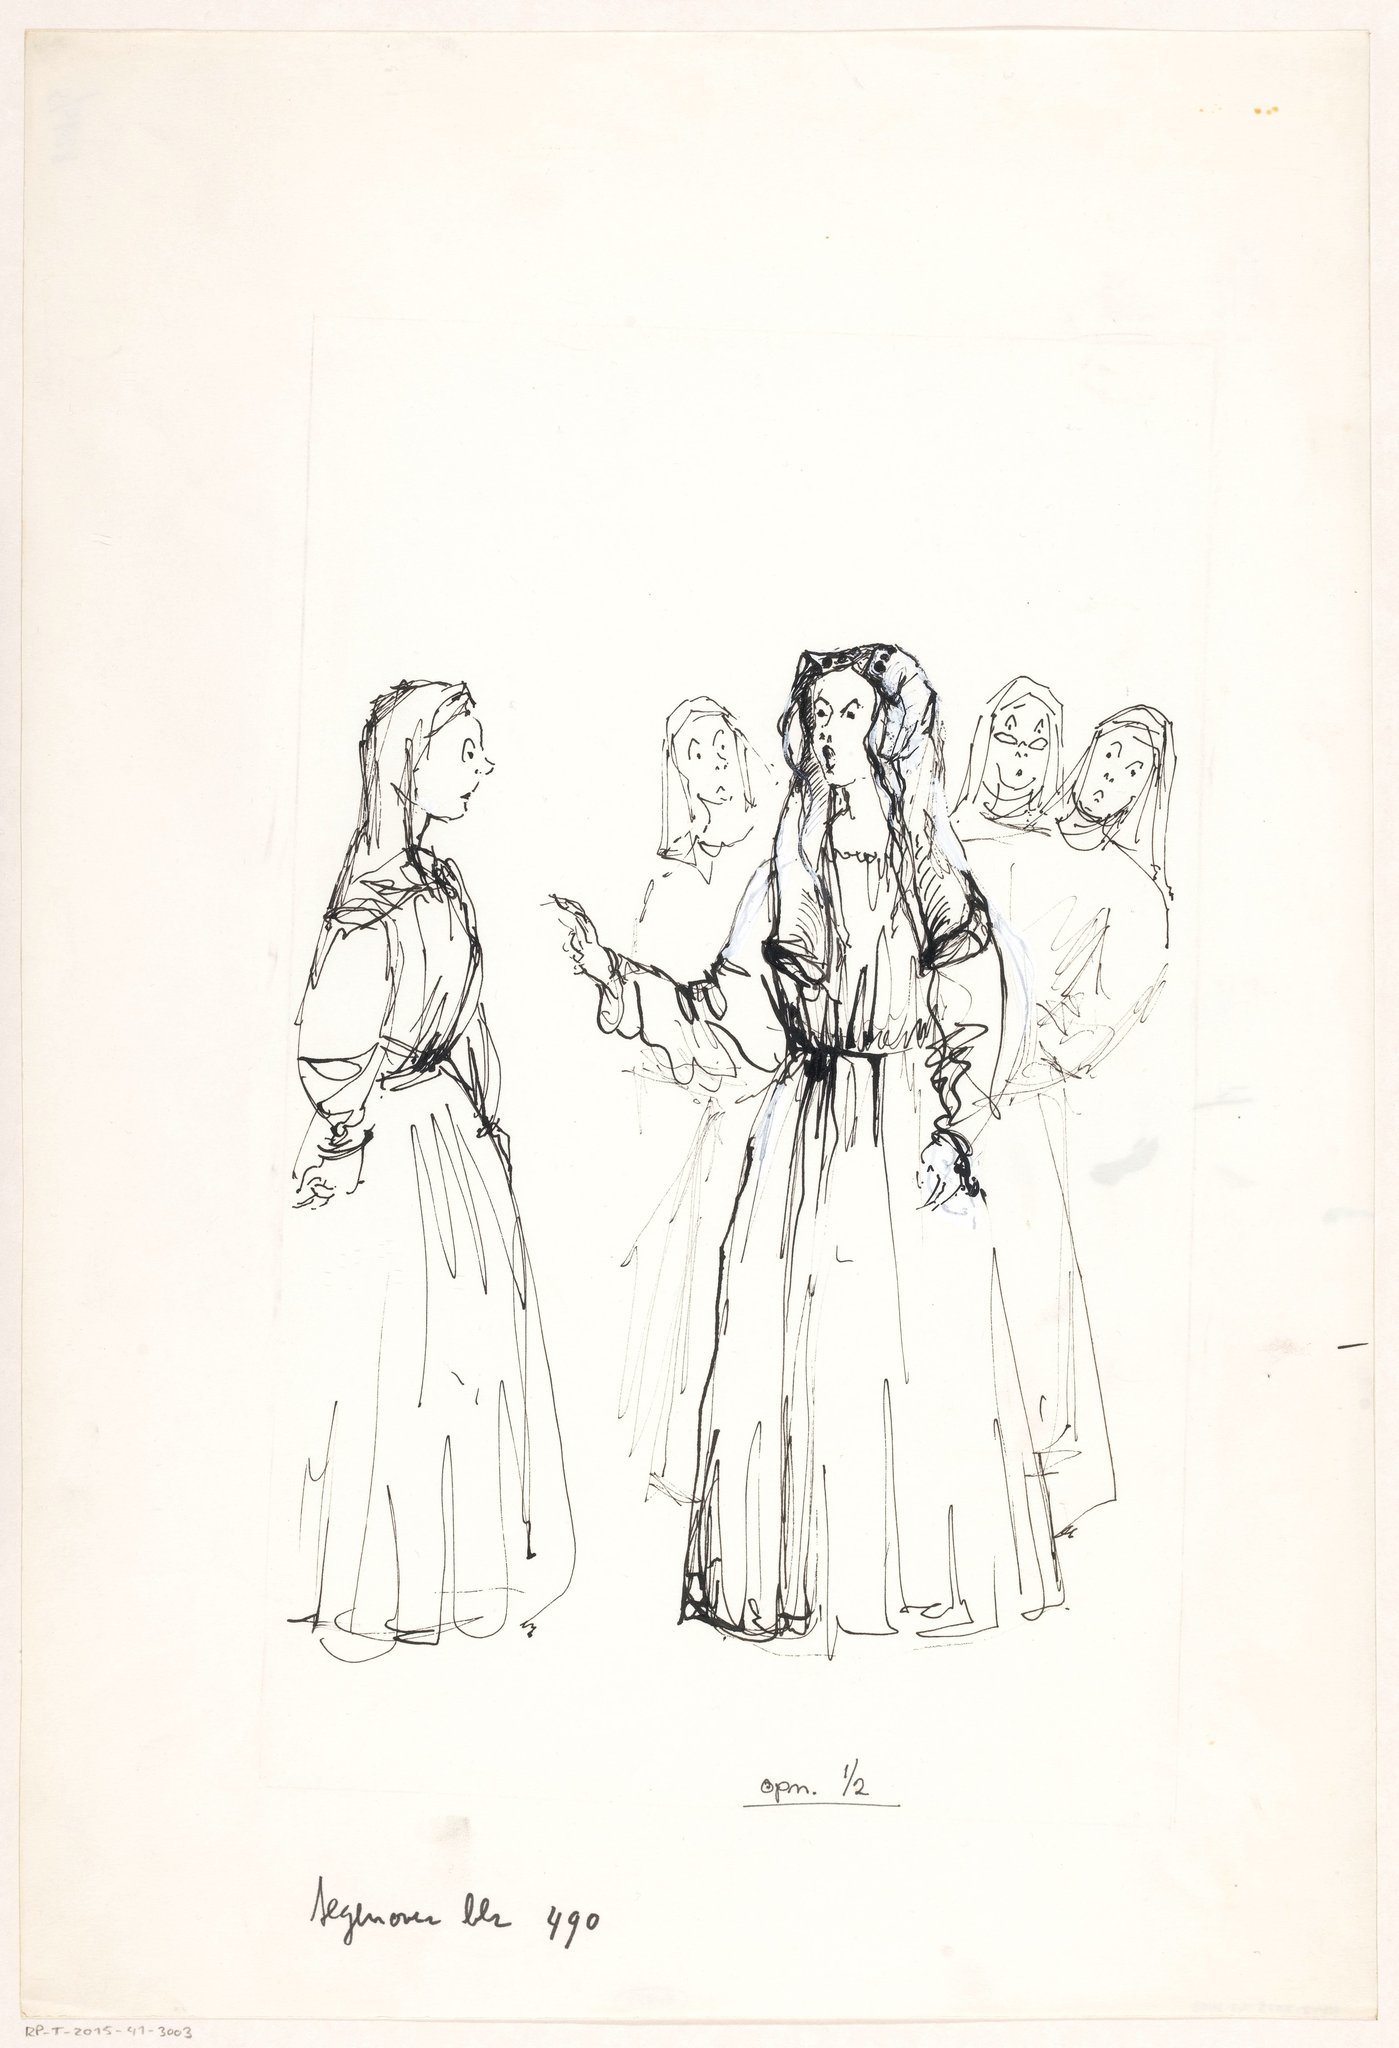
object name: drawing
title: Vrouw heft vinger op naar een vrouw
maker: Anonymous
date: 1900-1970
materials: paint, ink, paper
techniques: brush, pen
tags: nun(s), postures and gestures of hand and fingers (+ relations with aggressive, hostile character (expressive connotations)), veil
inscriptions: annotation: ‘tegenover blz 490’, :, collector's mark: Lugt 2228a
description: Een vrouw met een sluier heft haar vinger op naar een vrouw die schuin tegenover haar staat. Achter de vrouw die de vermanende beweging maakt staan drie nonnen verbaasd toe te kijken.